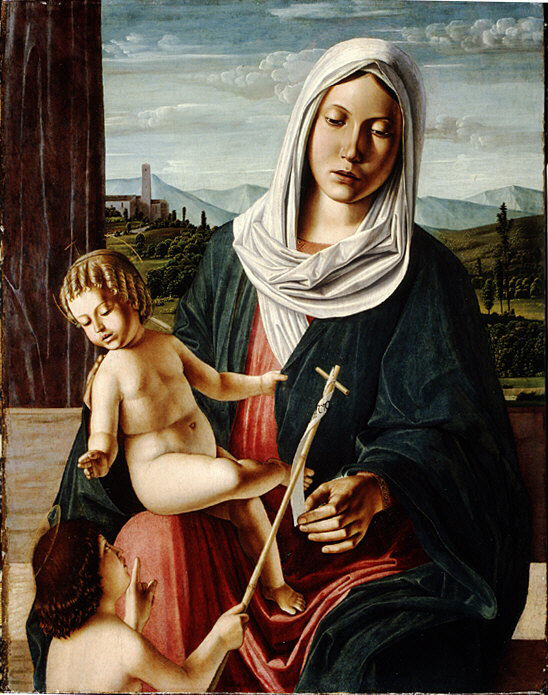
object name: painting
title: Madonna and Child with the Infant Saint John the Baptist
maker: michele da verona (michele di zenone)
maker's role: artist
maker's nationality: italian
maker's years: 1470-1537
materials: oil, paint, wood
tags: madonna and child,saint john the baptist,cross